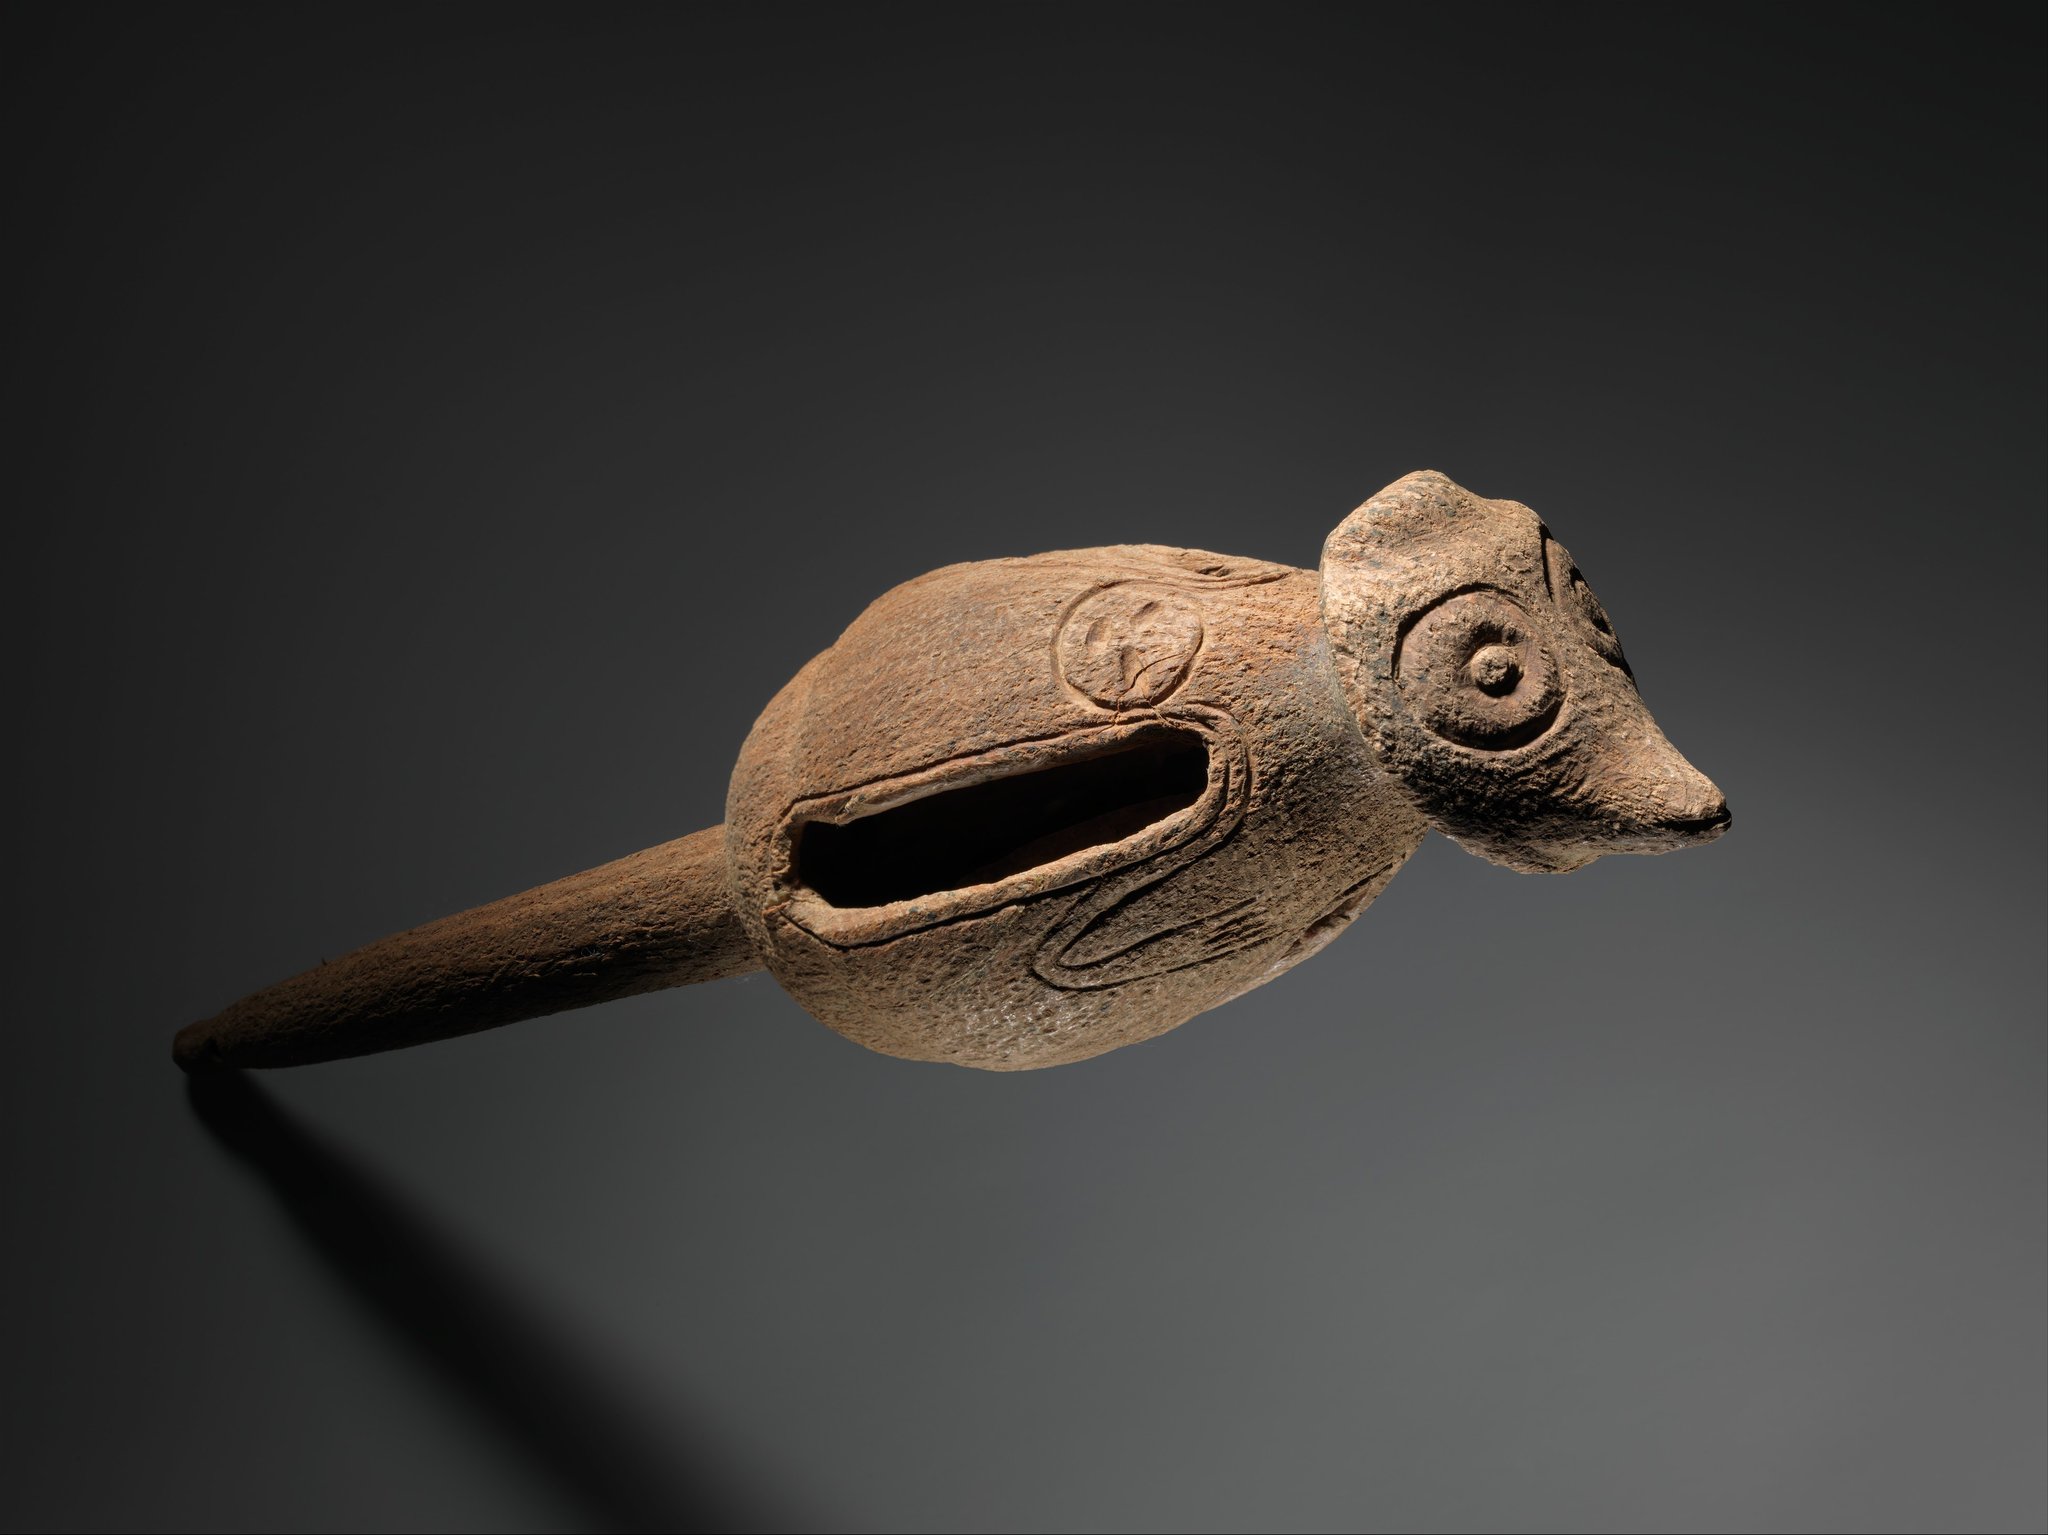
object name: rattle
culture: taino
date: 900-1550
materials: wood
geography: dominican republic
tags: animals